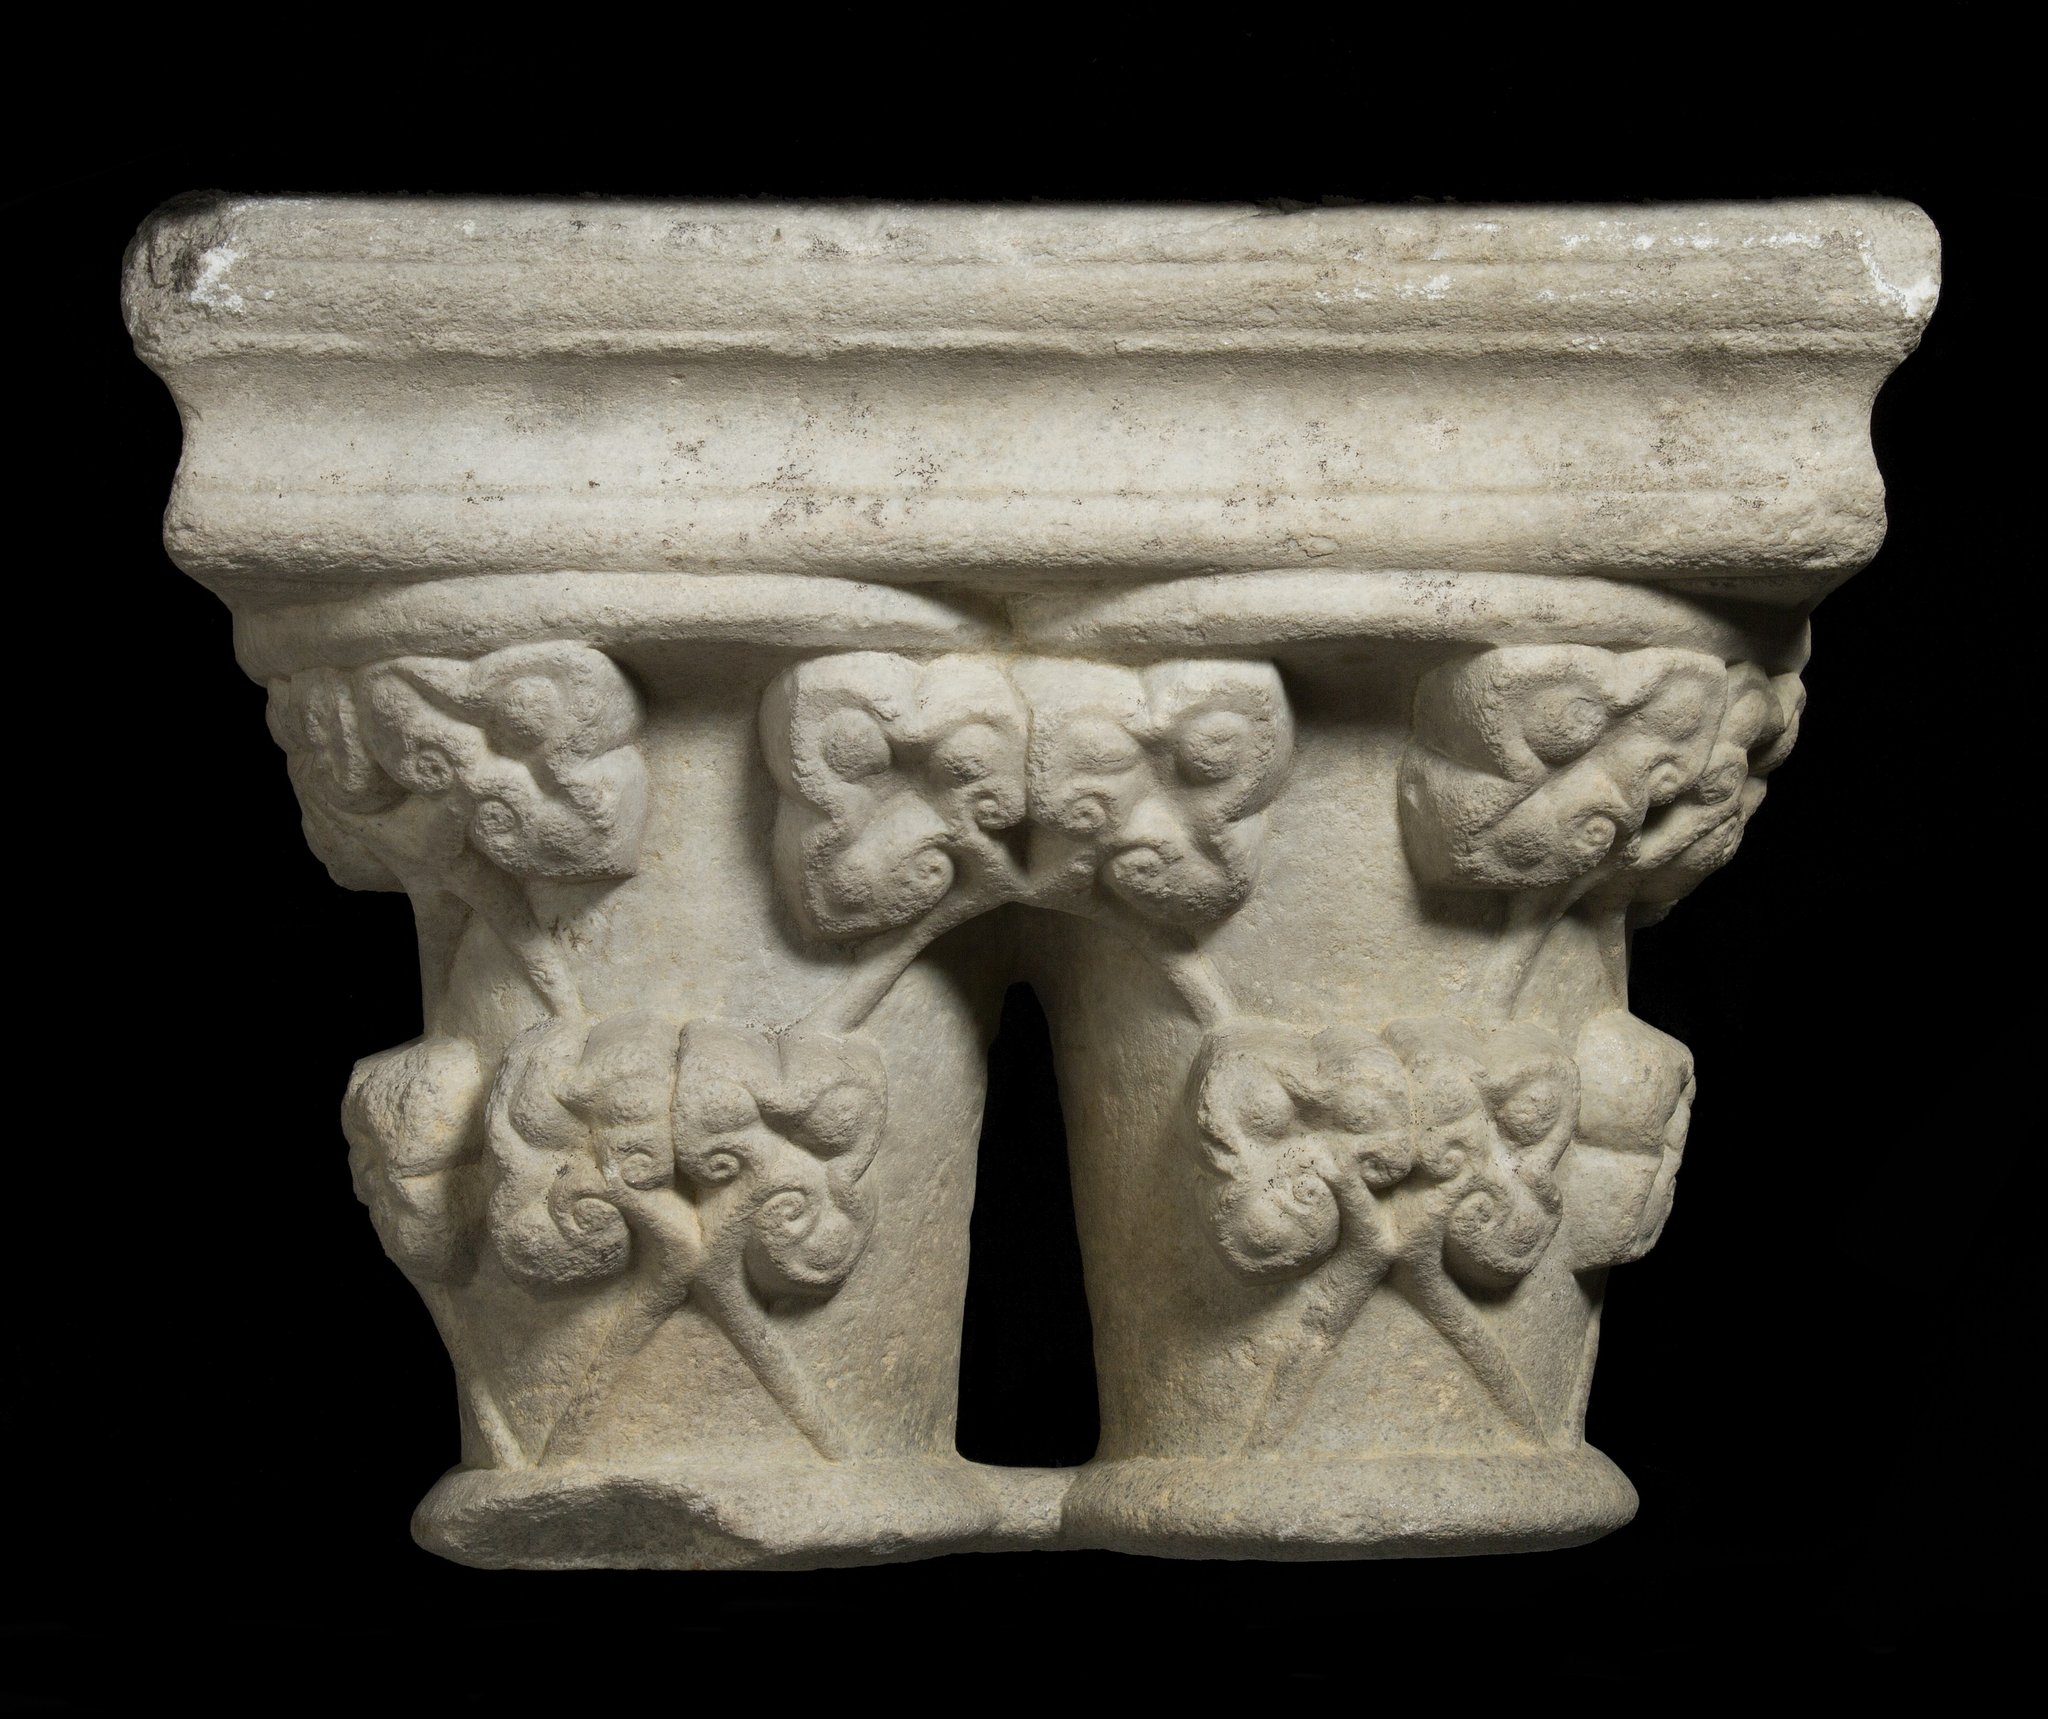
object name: capital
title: Double Capital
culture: french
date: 1267-1333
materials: marble